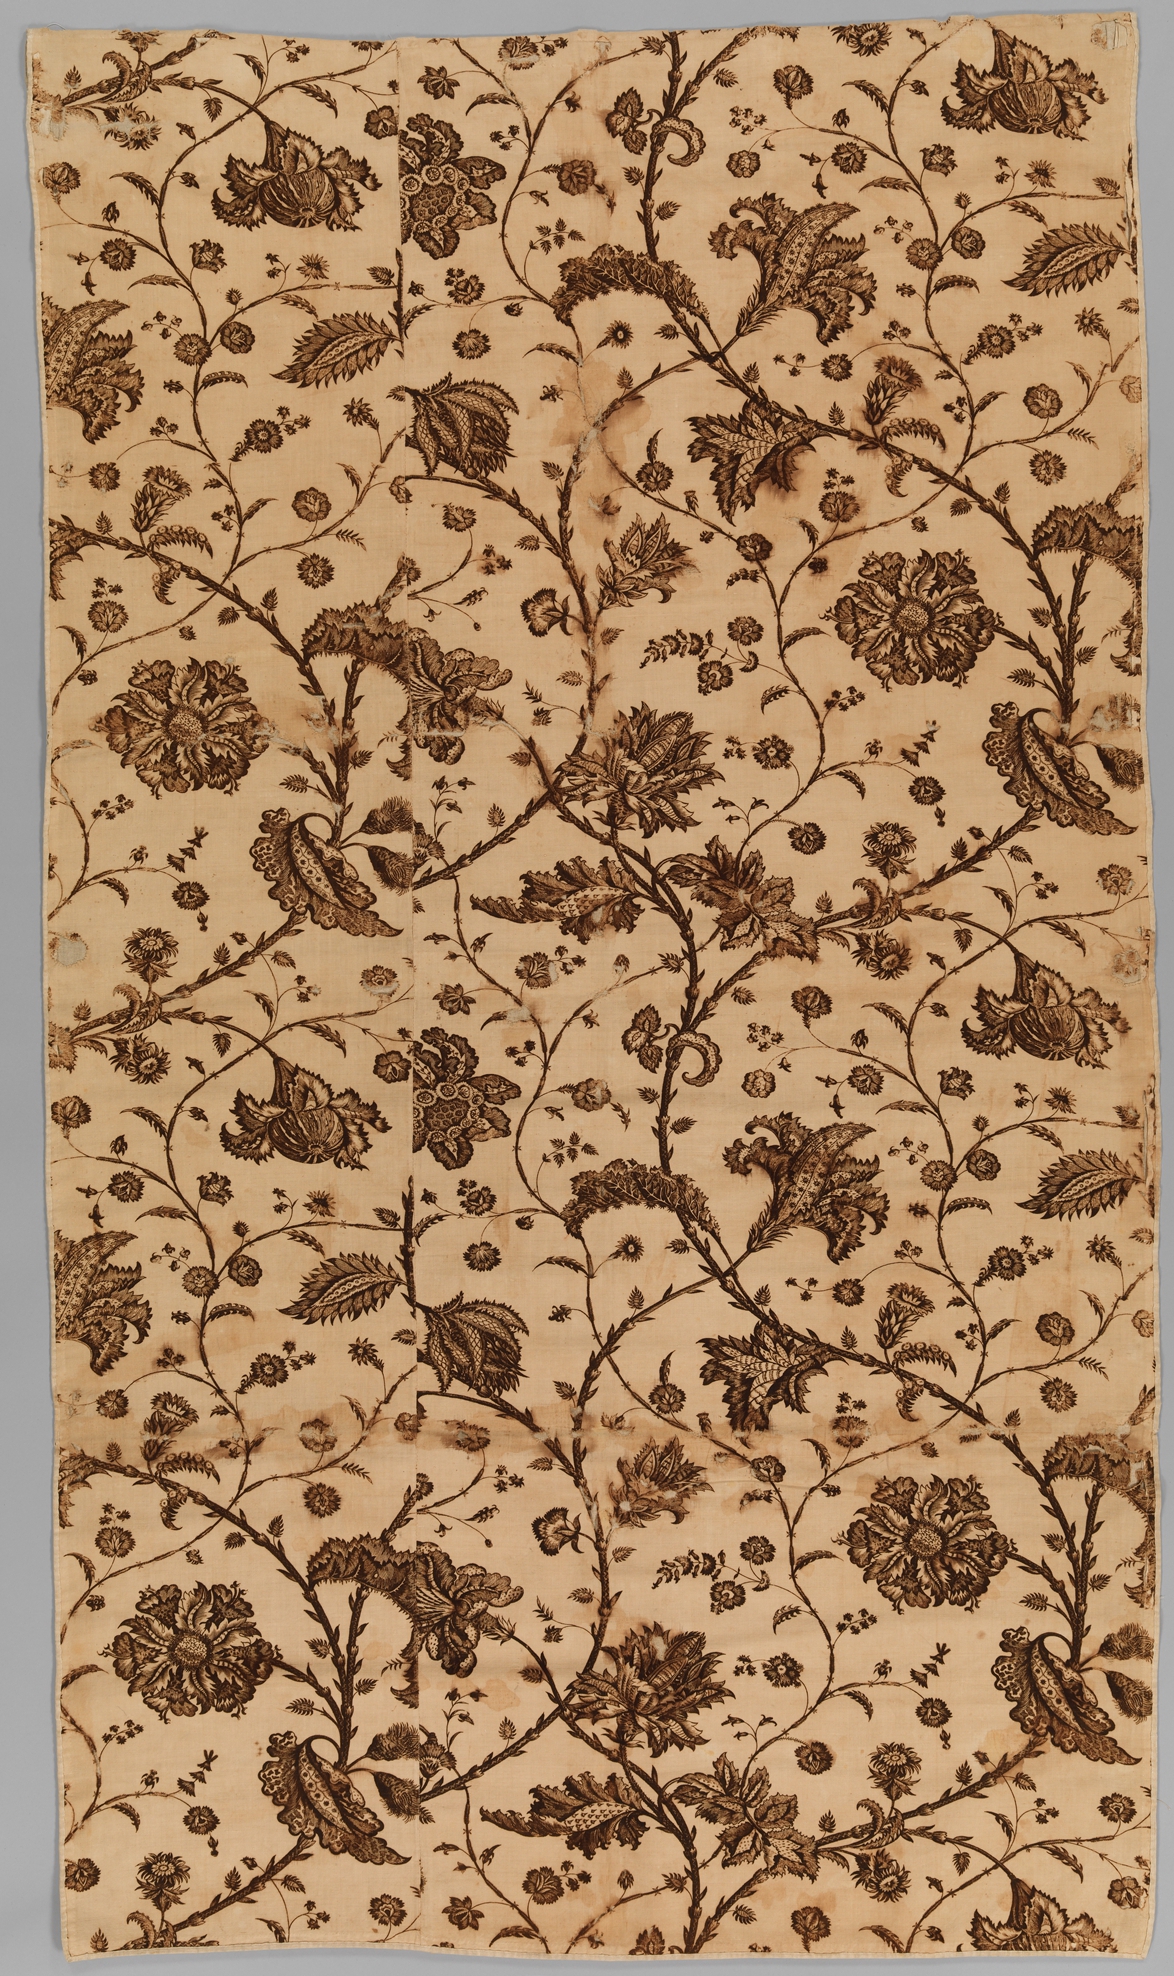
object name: piece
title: Floral printed cotton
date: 1780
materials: cotton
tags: flowers